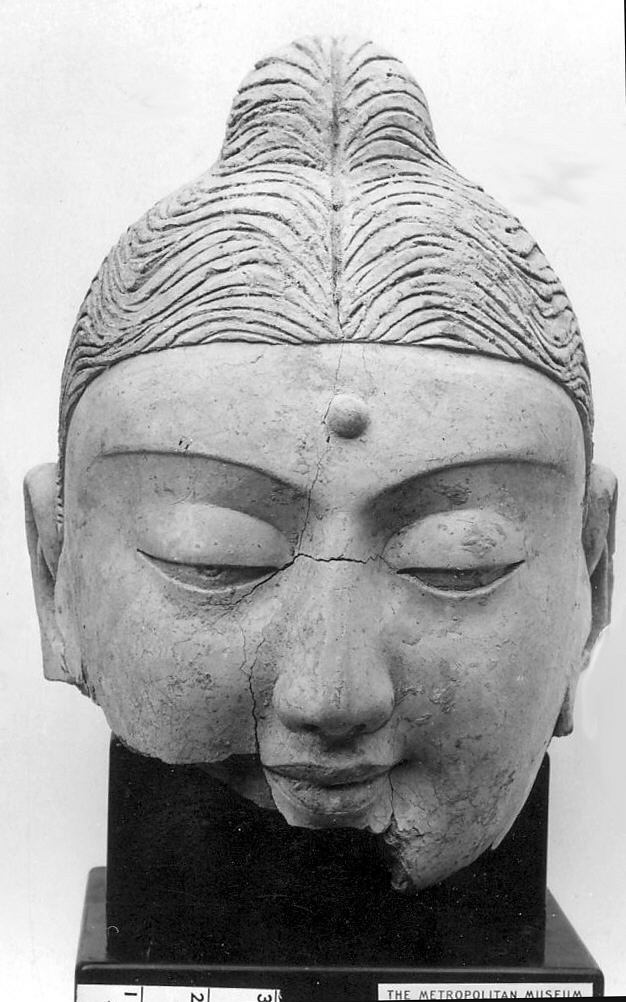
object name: head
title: Head of a Bodhisattva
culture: central asian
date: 201-700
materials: plaster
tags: heads,buddhism,bodhisattvas